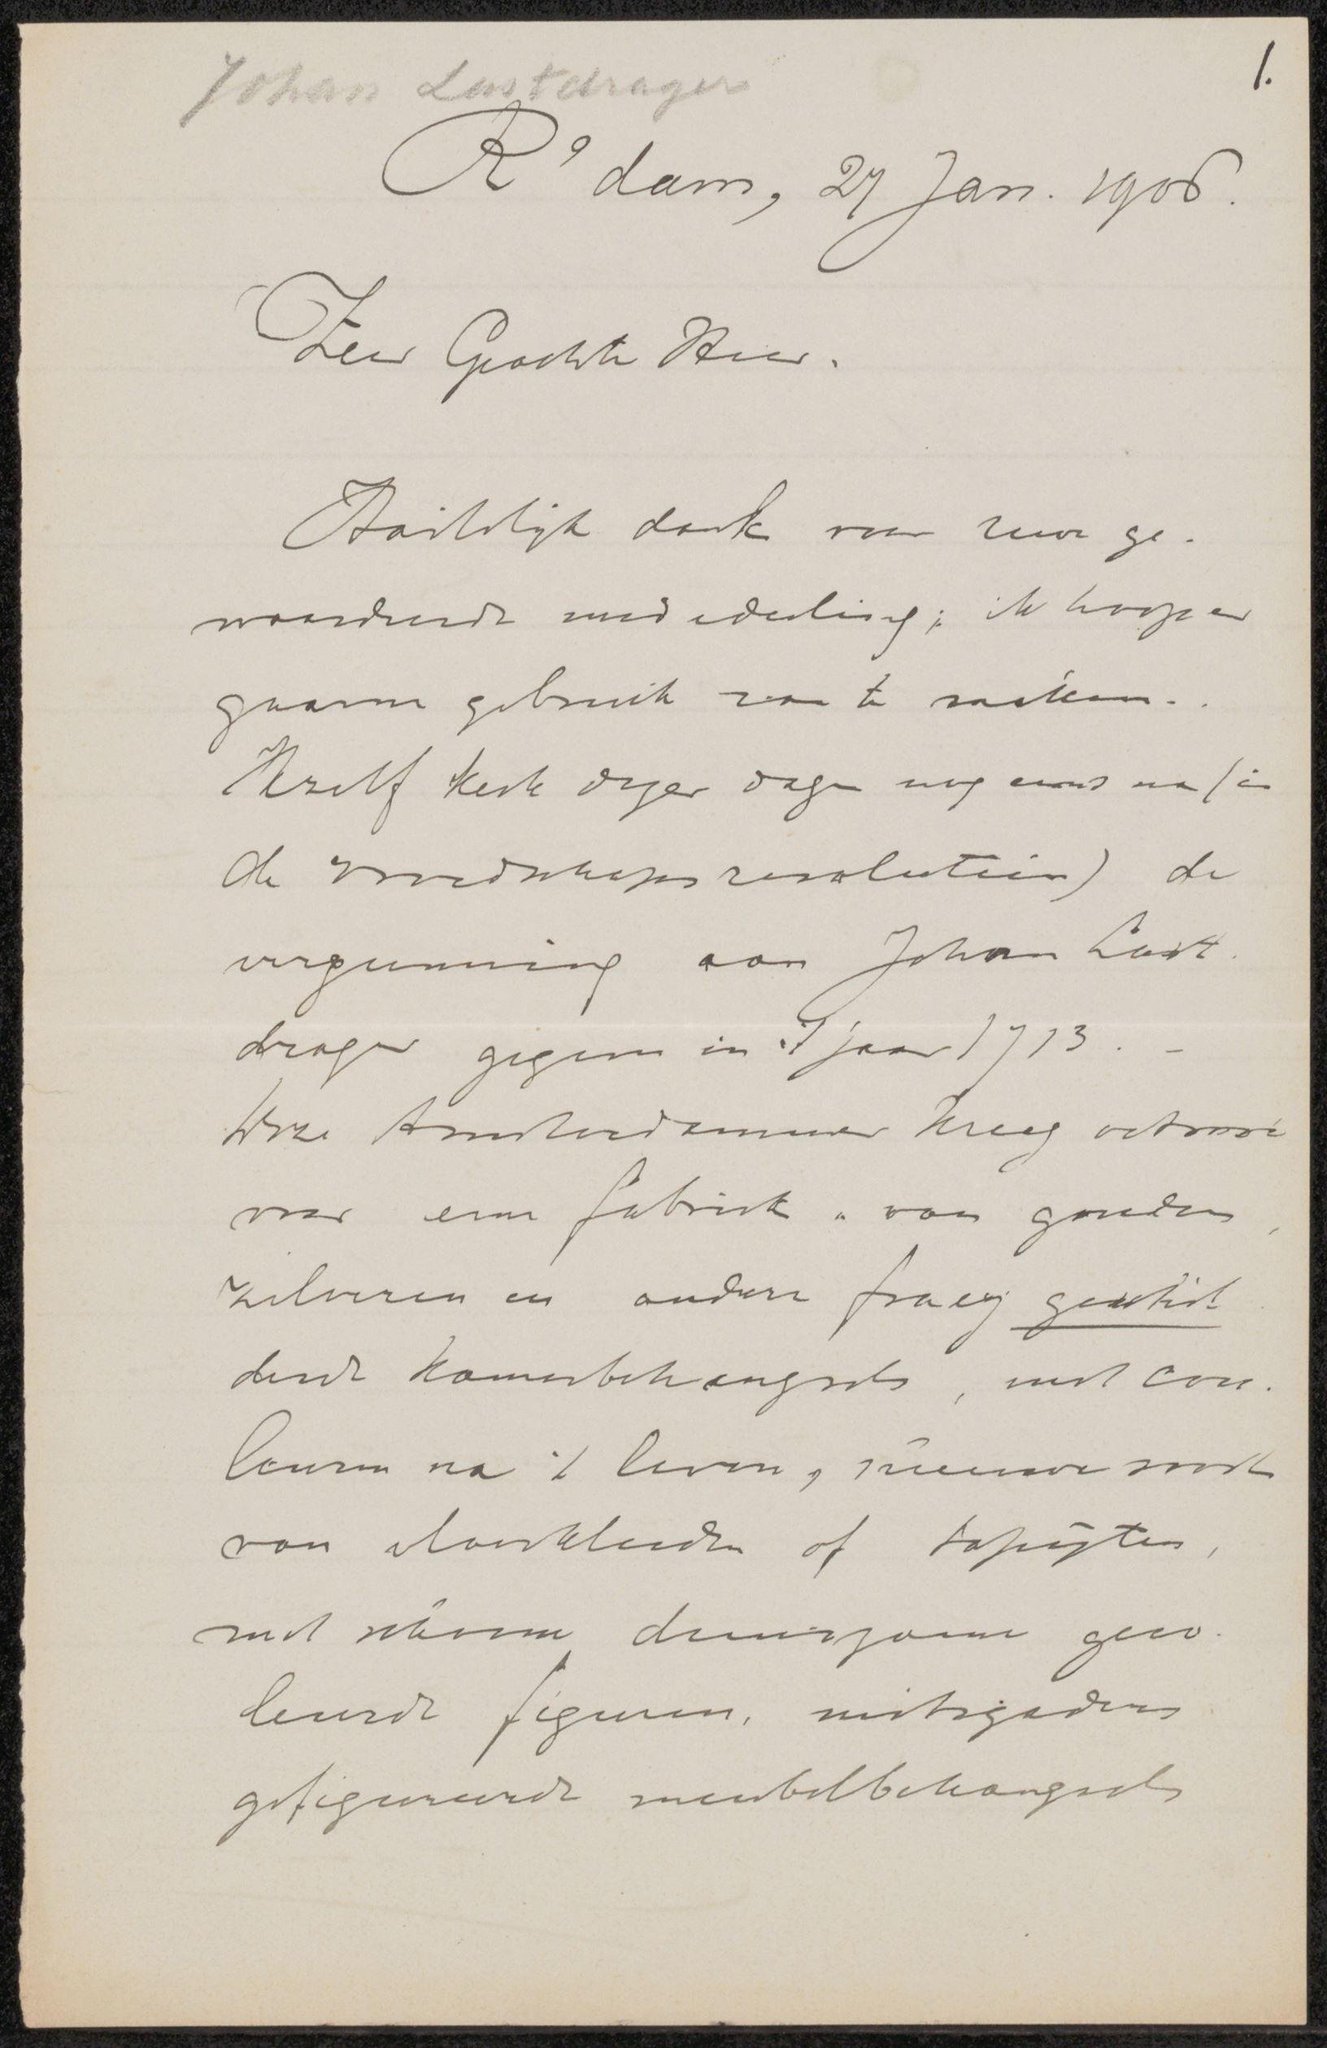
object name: letter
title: Brief aan M.D. Haga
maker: c. te lintum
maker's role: auteur, leraar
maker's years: 1863-1930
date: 1906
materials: ink, paper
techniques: pen, writing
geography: rotterdam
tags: painter, applied arts, arts and crafts; industrial design